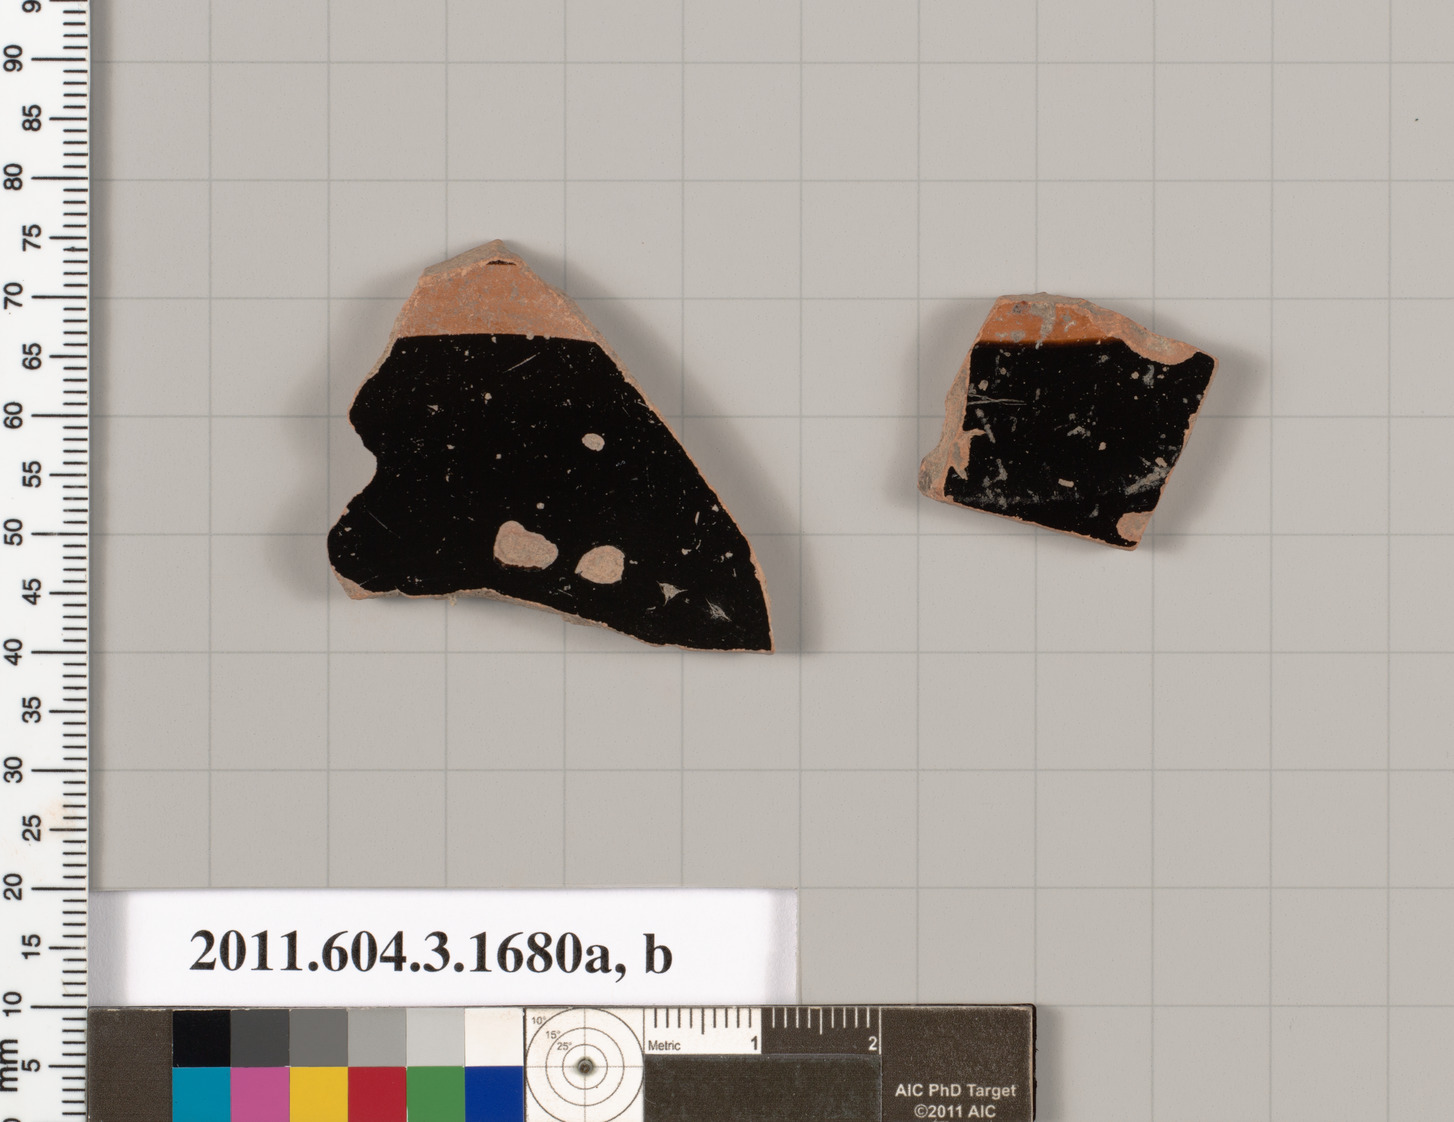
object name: kylix fragment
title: Terracotta fragments of kylikes: Band or lip cups (drinking cups)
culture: greek, attic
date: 550-526 BCE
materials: terracotta